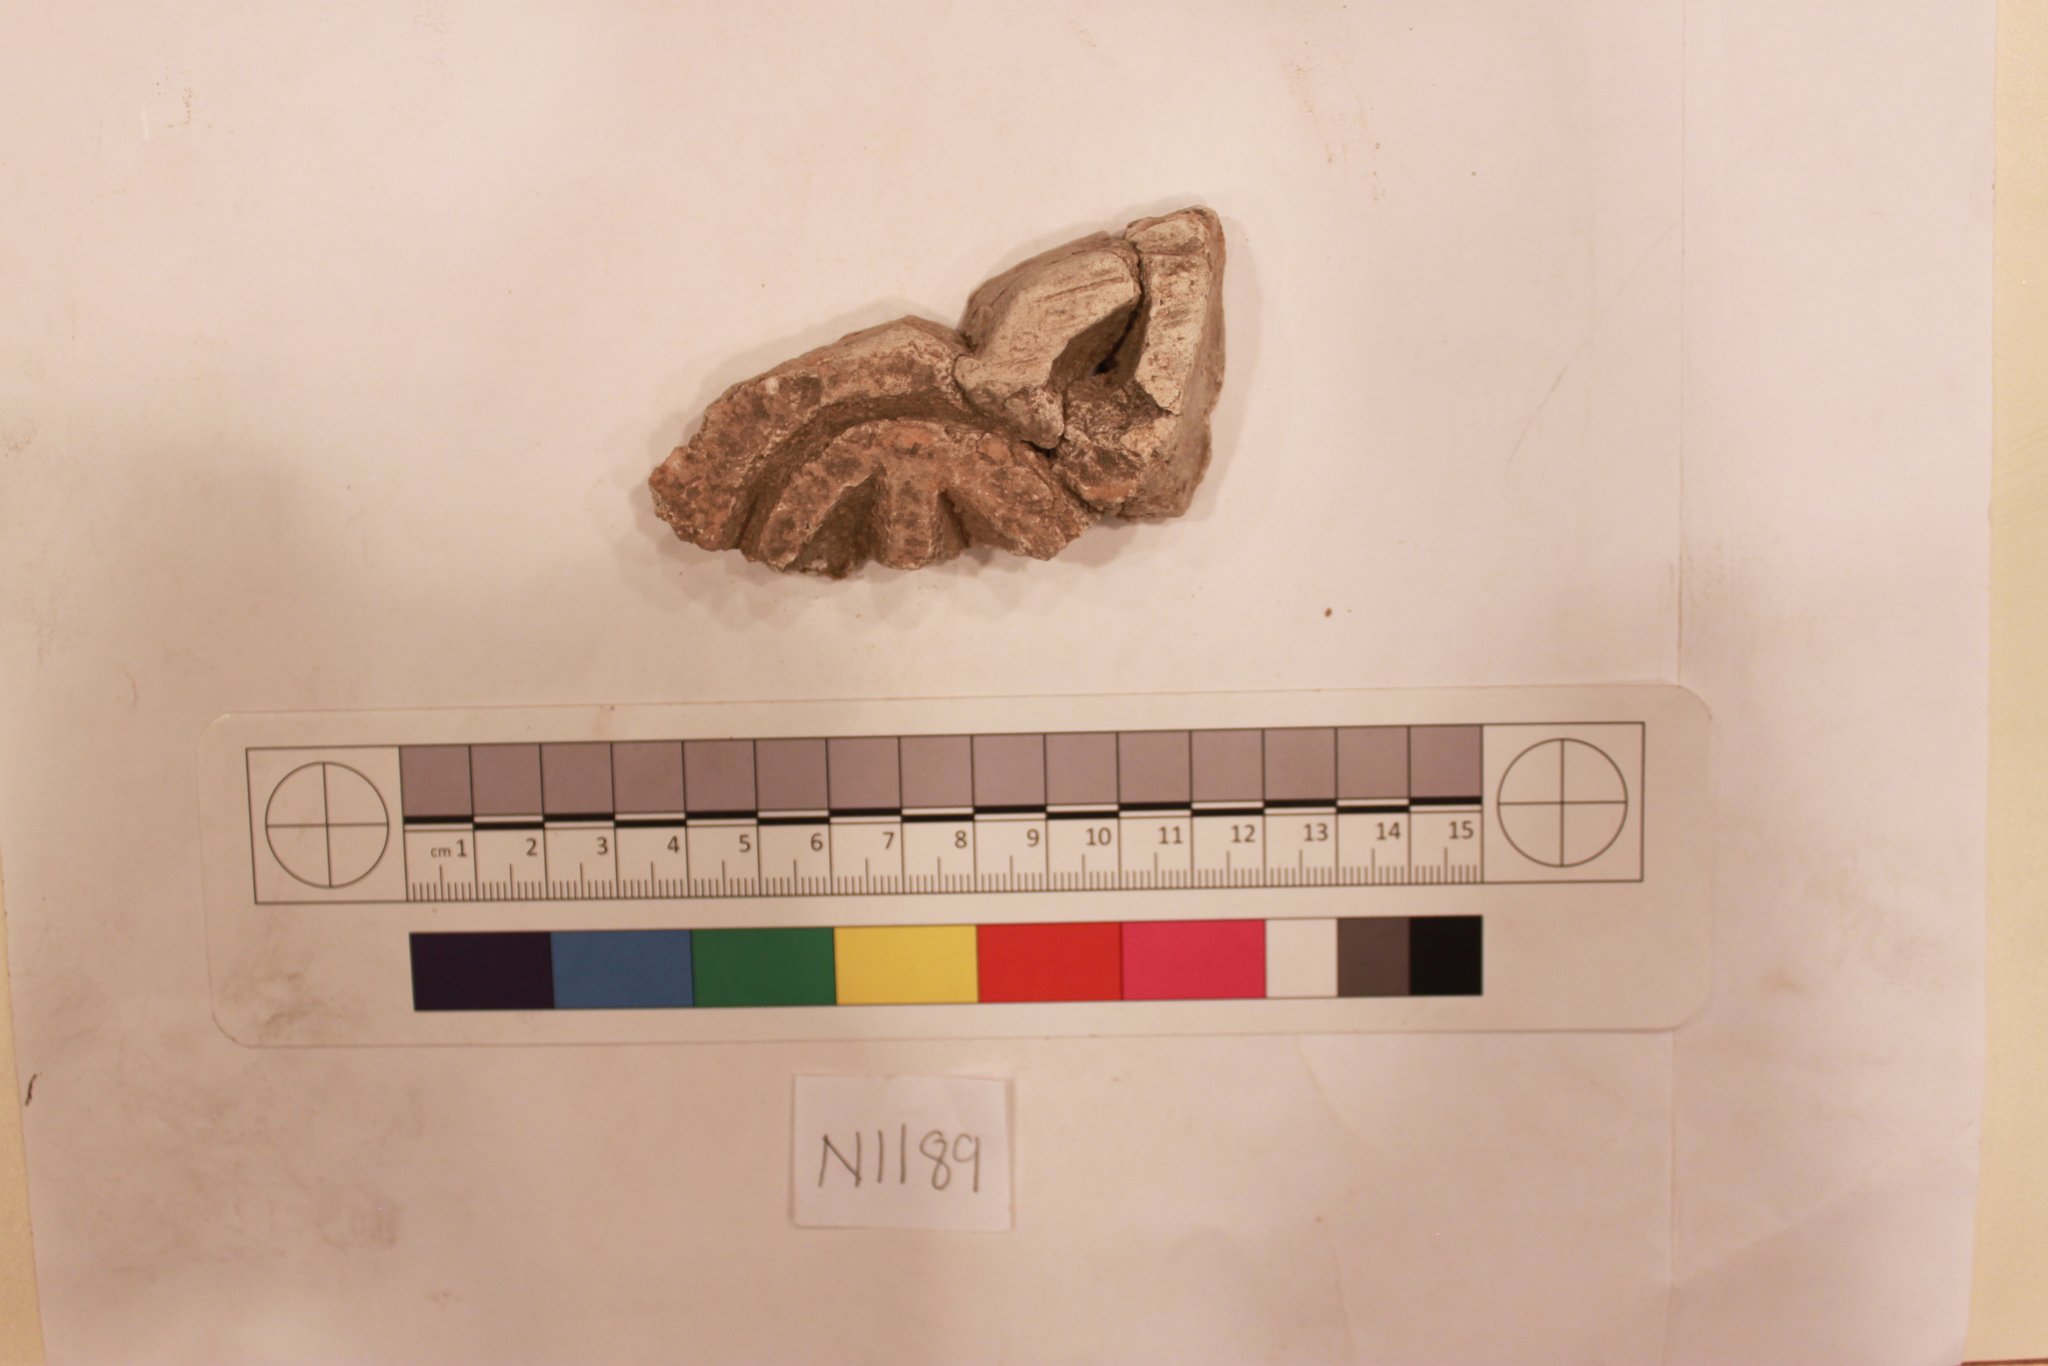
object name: fragment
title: Stucco Fragment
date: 701-1200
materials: plaster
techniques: carving, painting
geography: iran